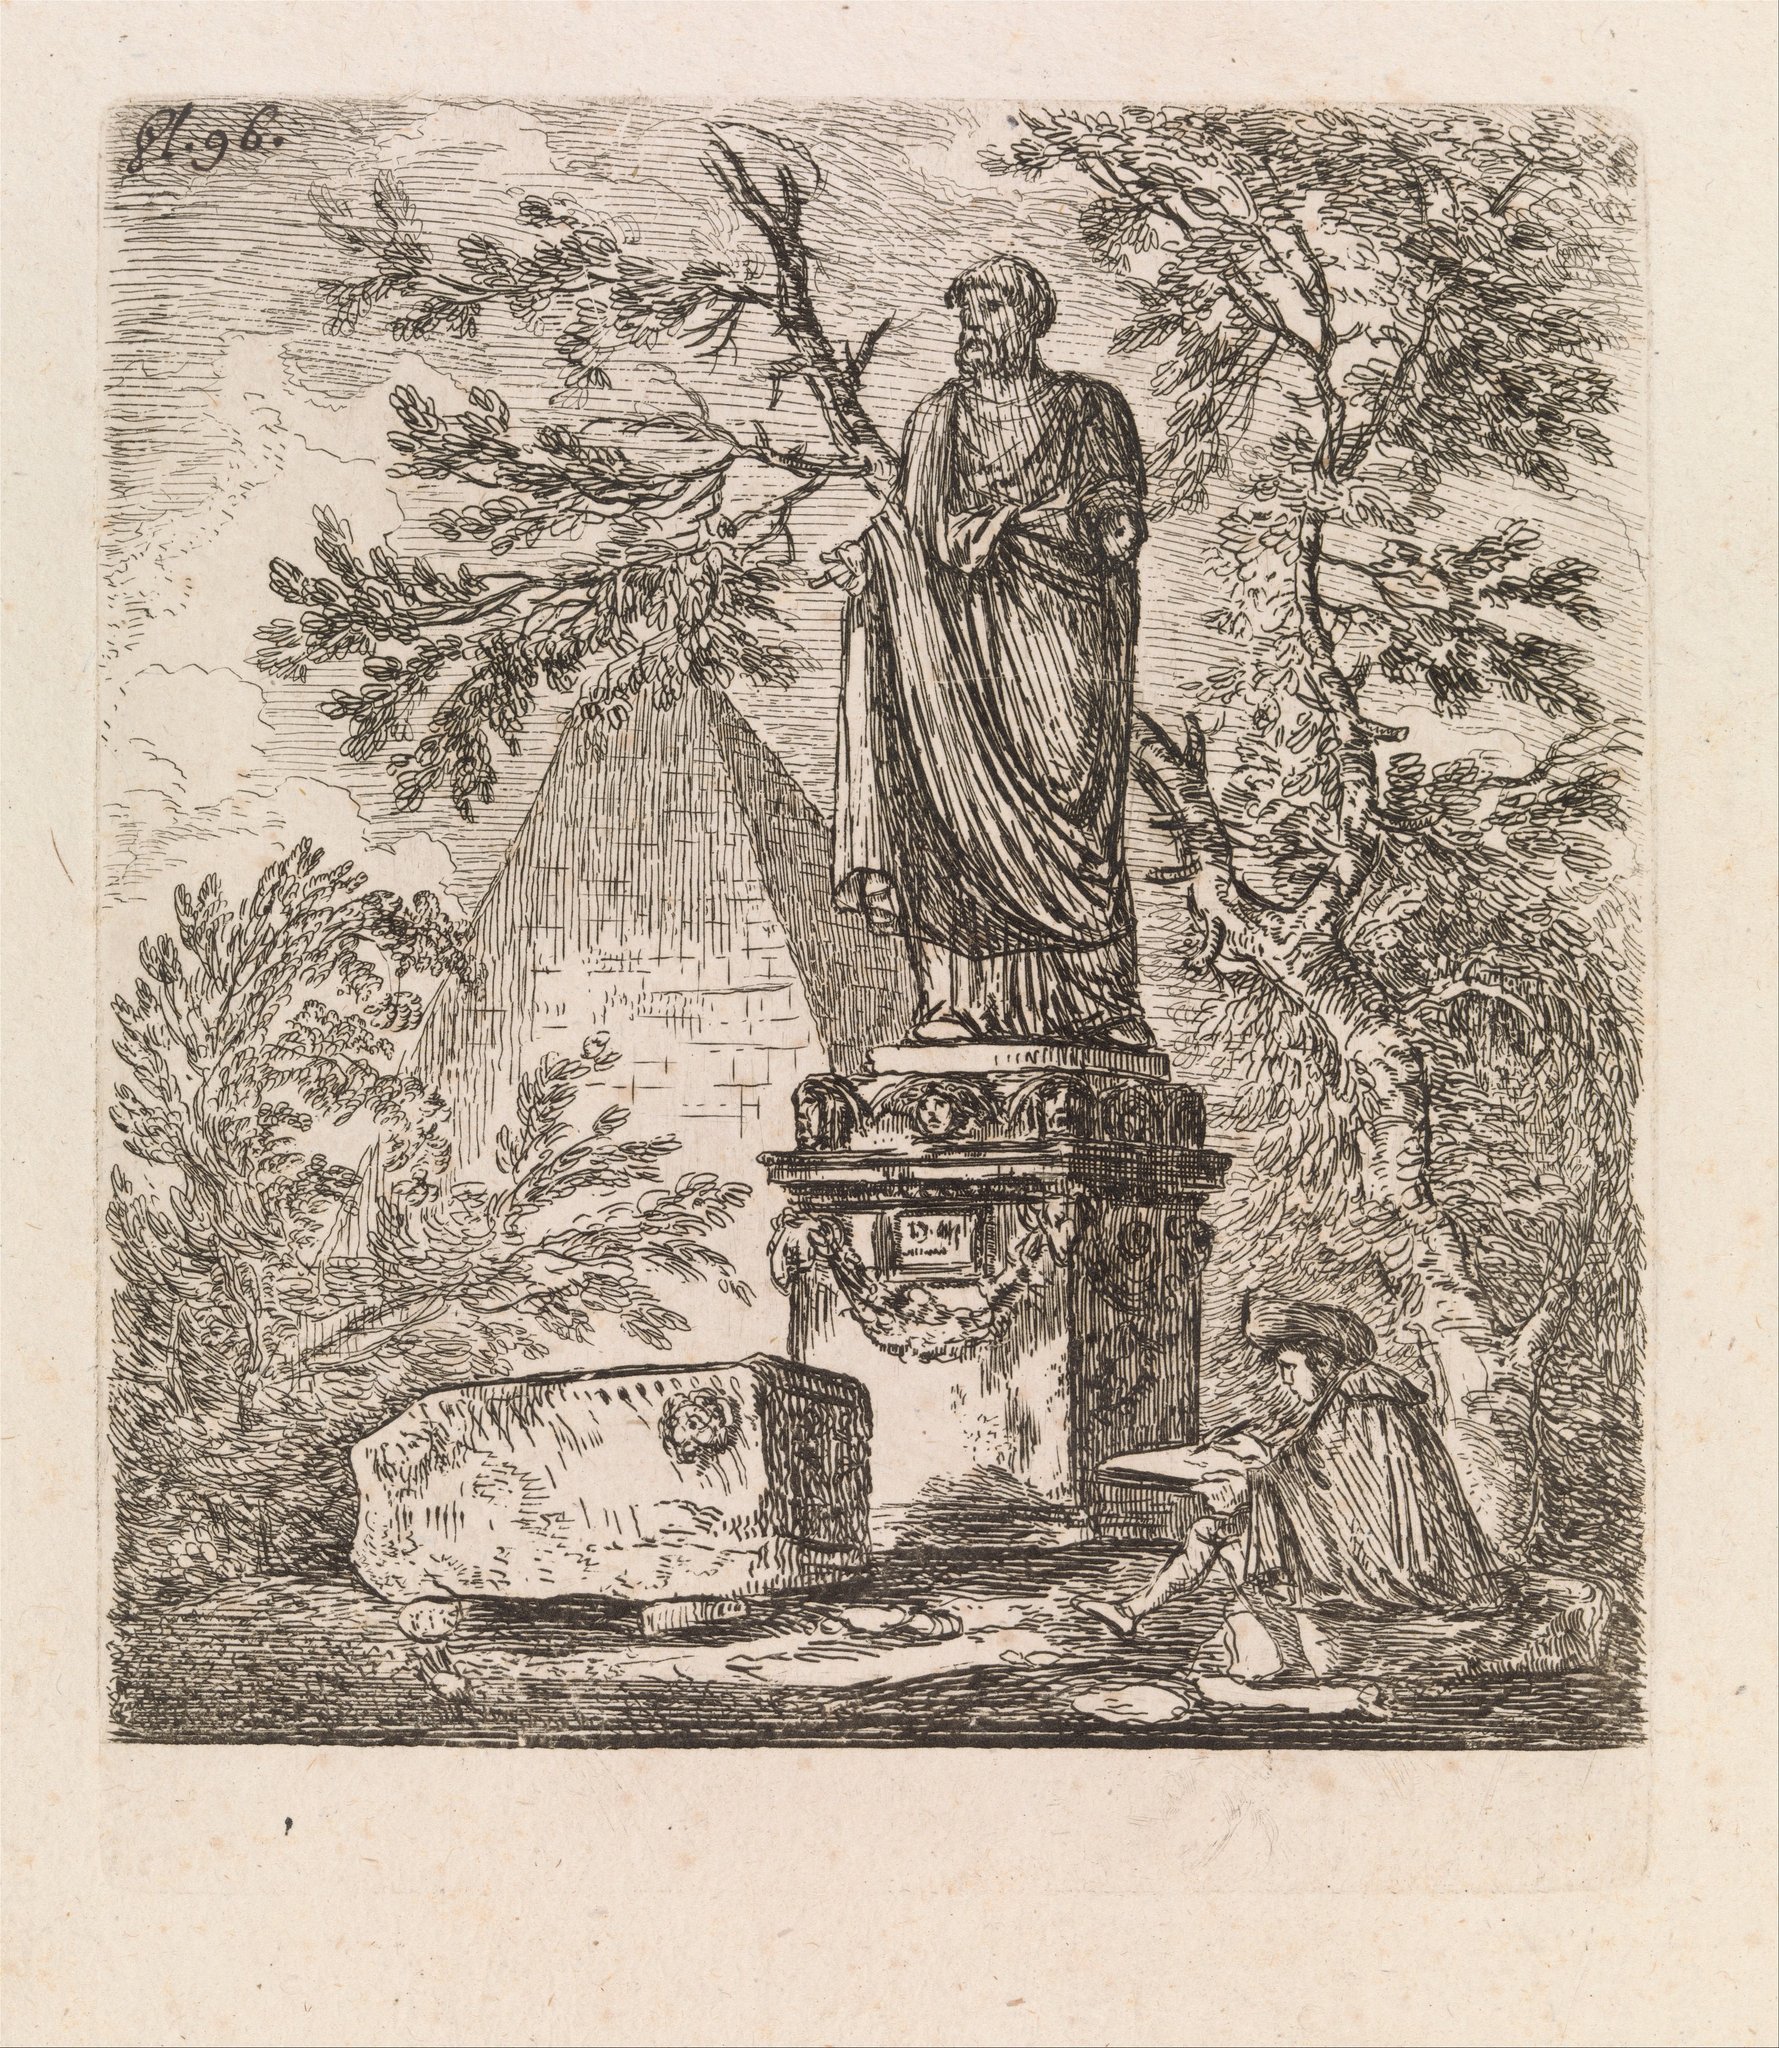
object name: book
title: Recueil de divers Monumens Anciens répandus en plusieurs endroits de L'Italie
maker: jean barbault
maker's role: designer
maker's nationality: french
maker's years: 1718-1762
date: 1770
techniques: engraving, etching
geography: italy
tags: monuments,pyramids,men,trees